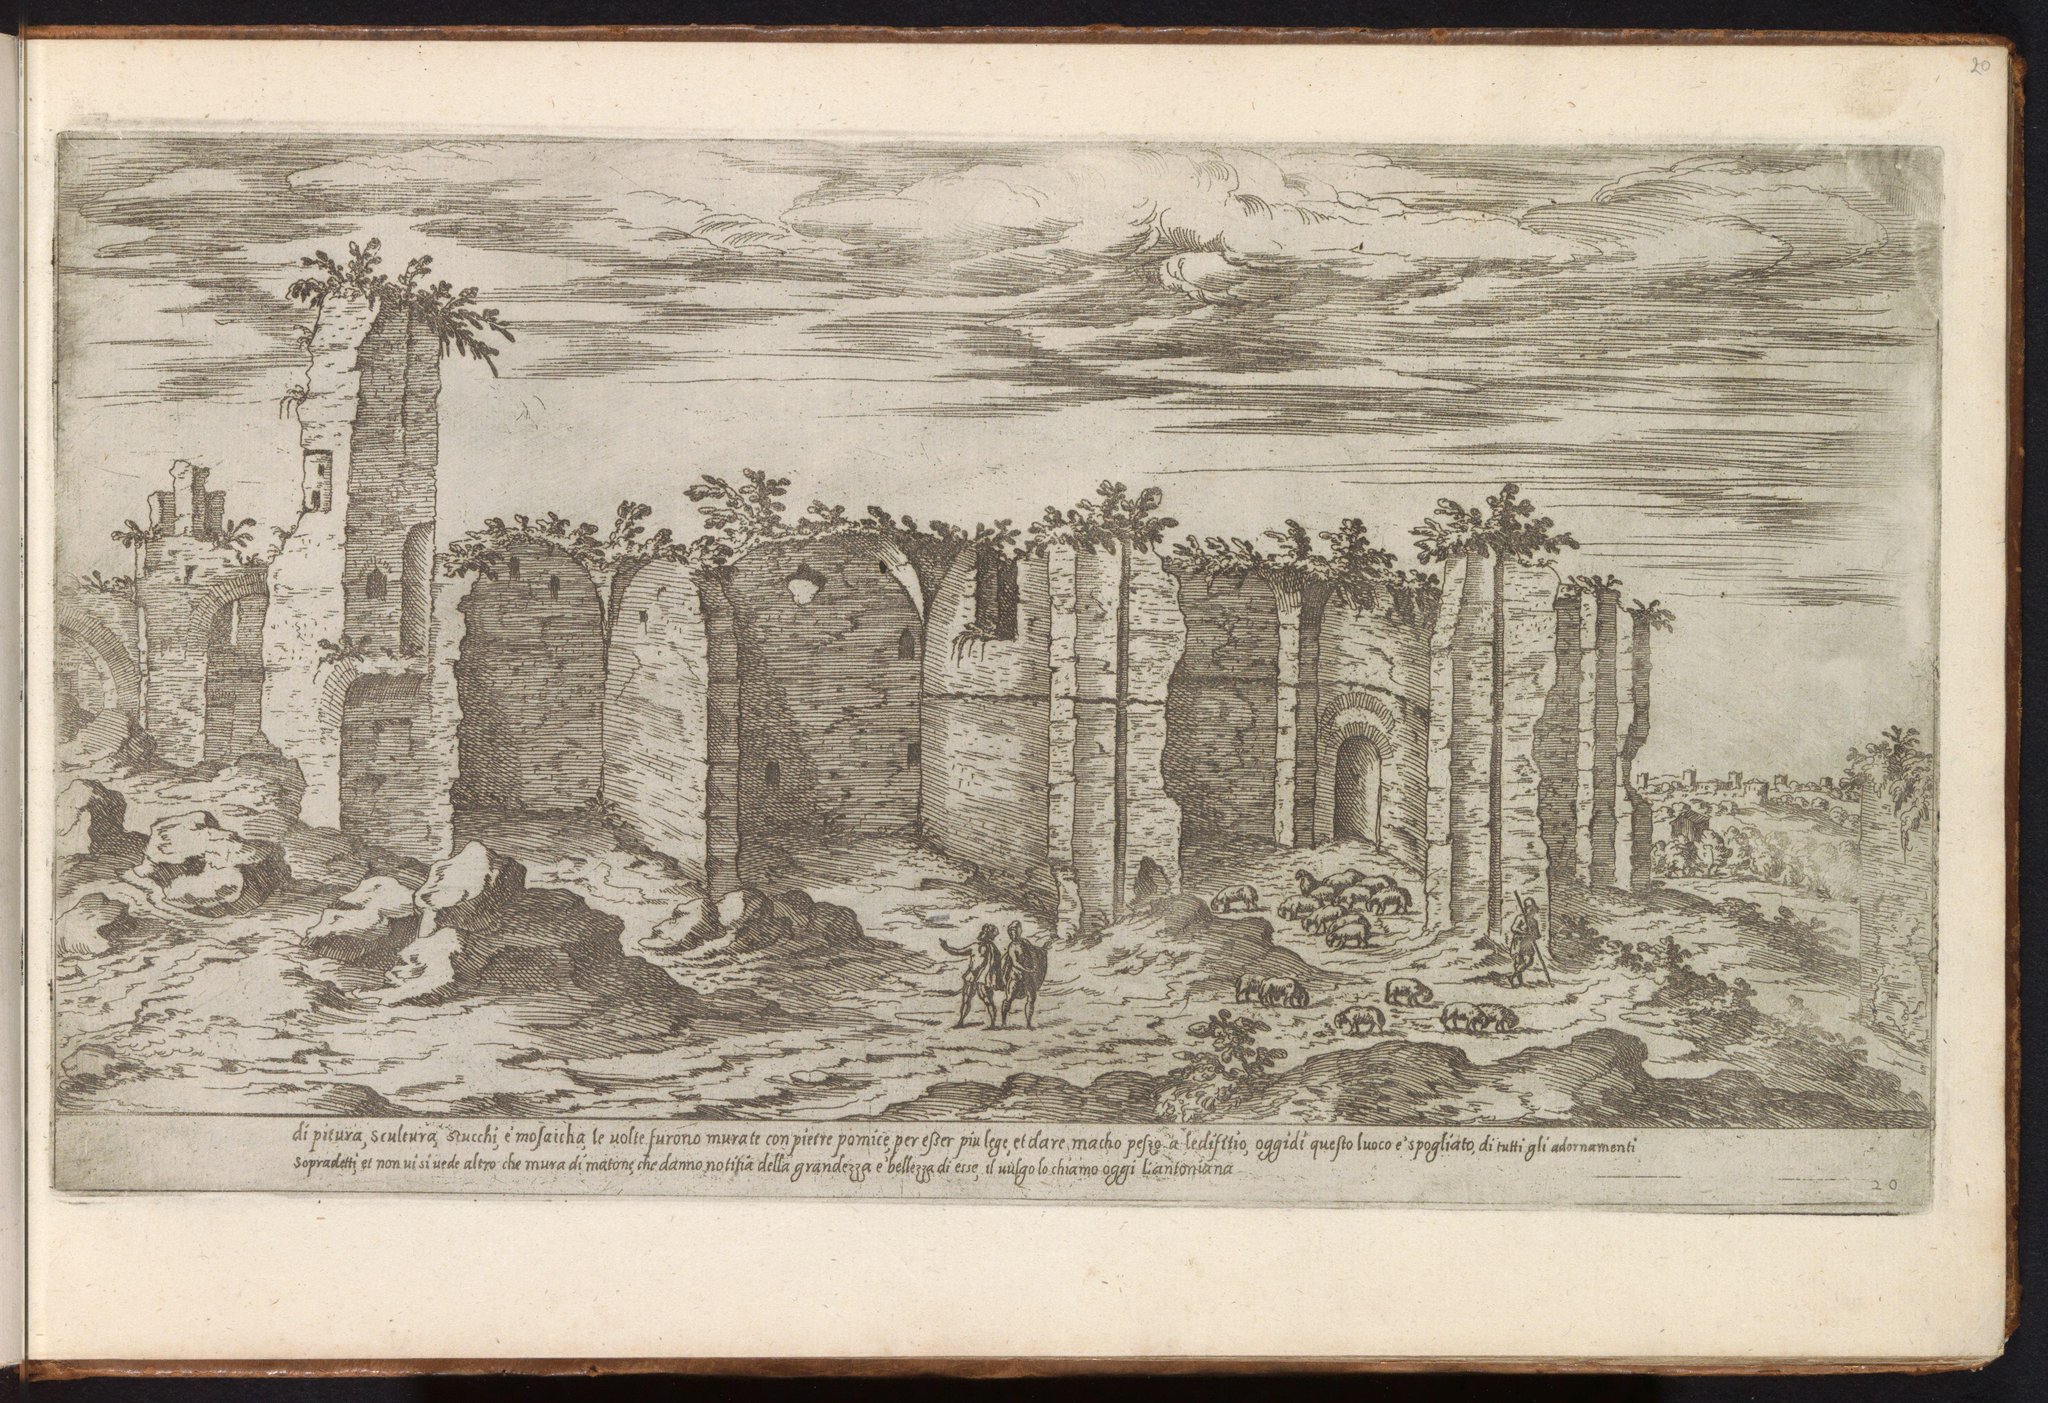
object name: print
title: Ruïnes van de Thermen van Caracalla te Rome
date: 1575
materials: paper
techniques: engraving, etching, intaglio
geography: italy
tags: city-view, and landscape with man-made constructions, ruin of a building ~ architecture, landscape with ruins, public baths - aa - in the open air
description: Gezicht op de ruïnes van de Thermen van Caracalla te Rome. Onderschrift in het Italiaans. Prent maakt deel uit van een album.